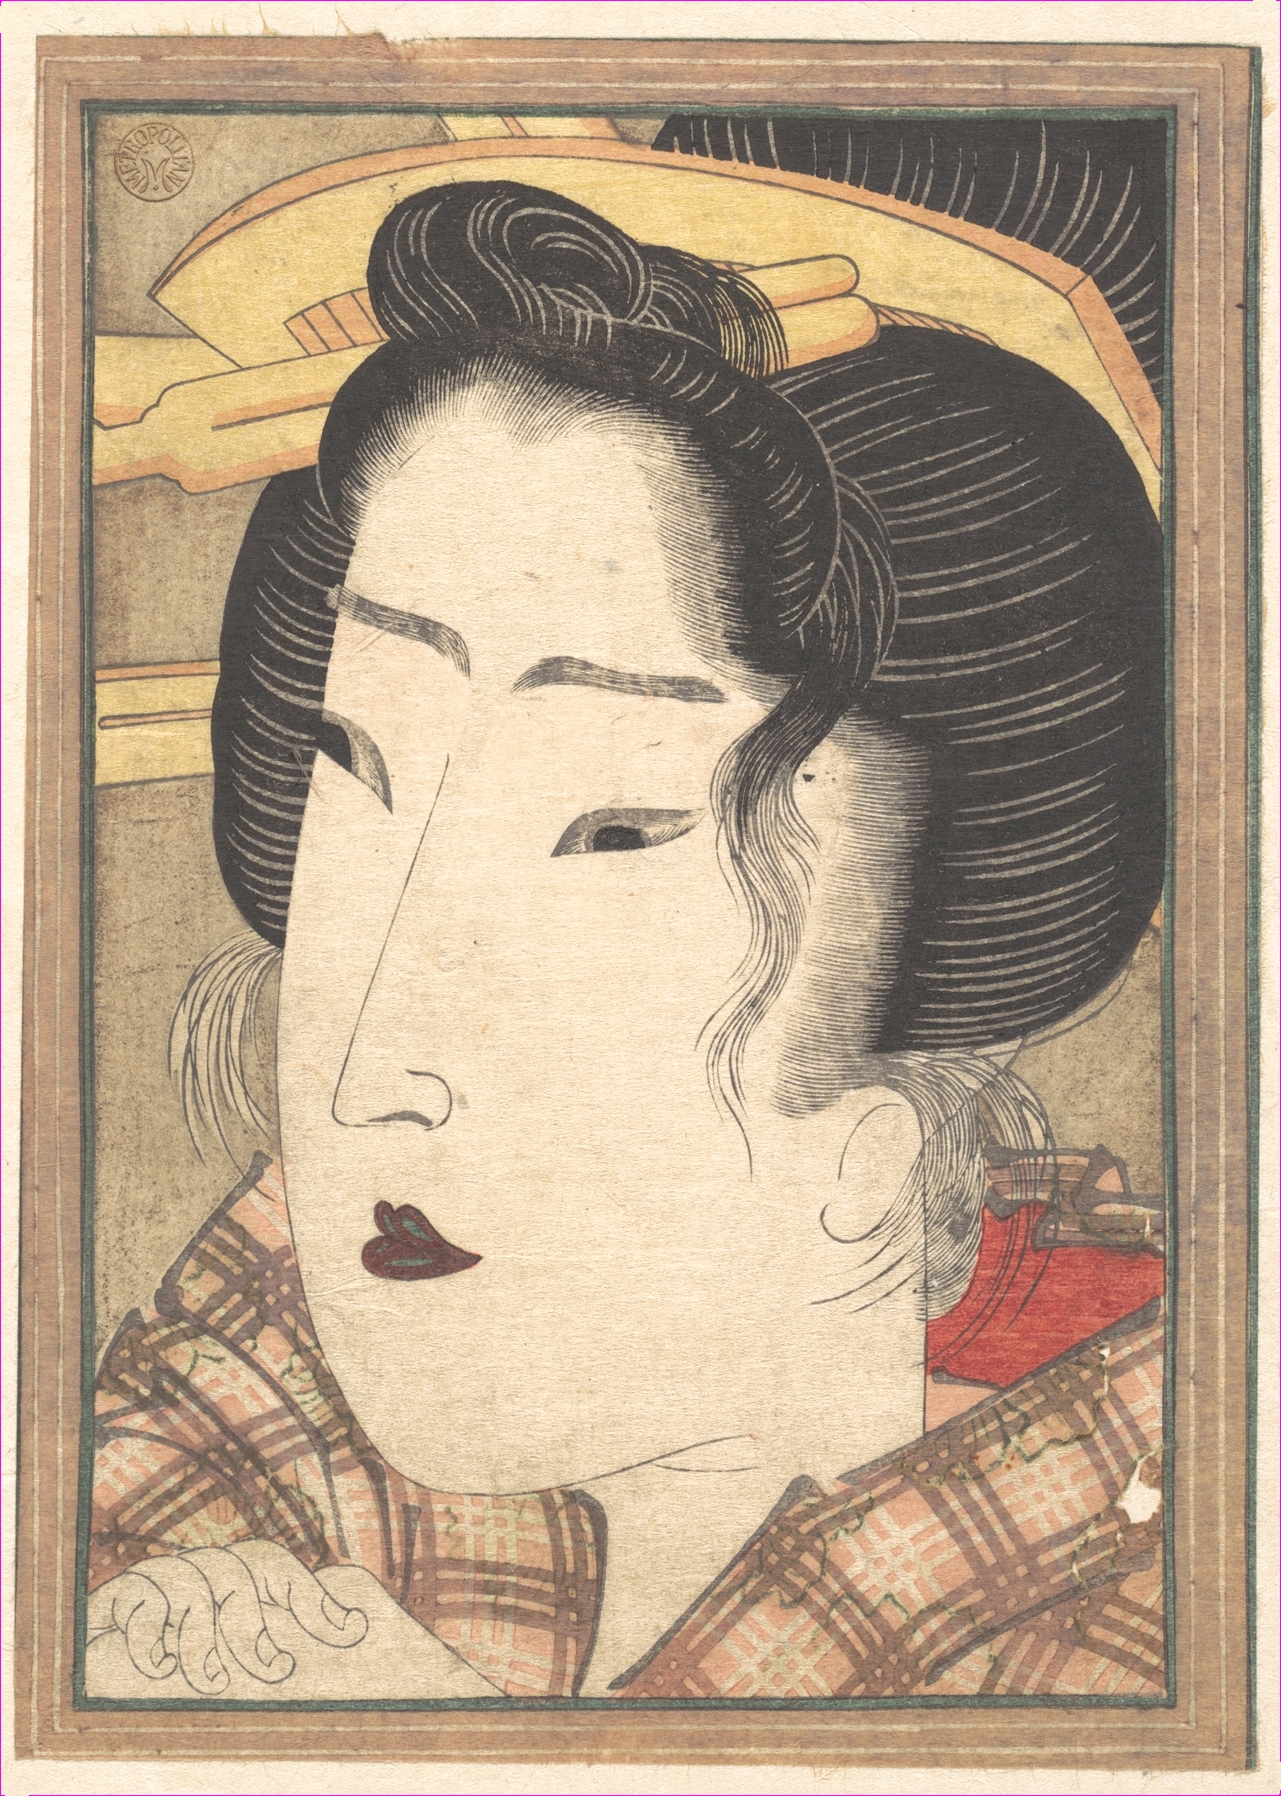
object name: woodblock print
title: Head of a Beauty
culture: japanese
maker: keisai eisen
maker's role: artist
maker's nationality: japanese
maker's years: 1790-1848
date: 1825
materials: ink, paper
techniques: woodblock print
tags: heads,women